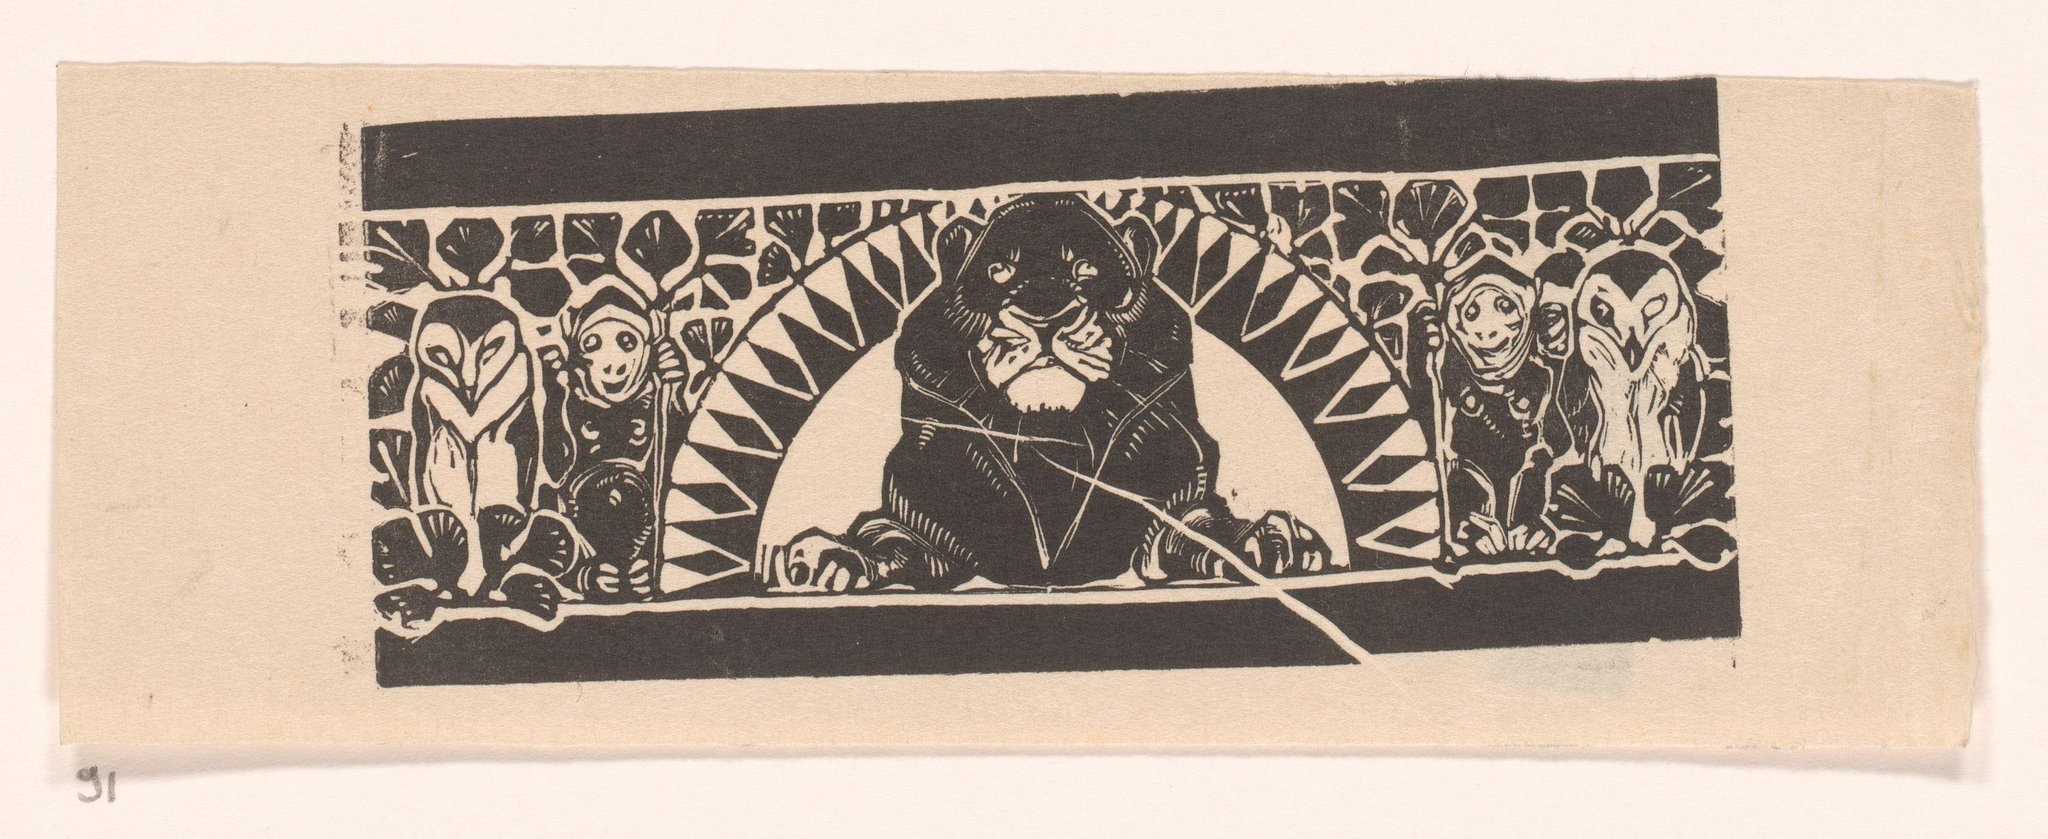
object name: boekillustratie ontwerp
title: Leeuw, uilen en apen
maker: bernard willem wierink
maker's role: draughtsman, print maker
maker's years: 1856-1939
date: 1910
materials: paper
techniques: relief print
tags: lion's head ~ ornament, monkeys, apes, owls, fable of reynard the fox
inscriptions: collector's mark: Lugt 2228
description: Ontwerp voor: Streuvels, Stijn (Frank Lateur). Reinaert de Vos naar verschillende uitgaven van het middeleeuwsche epos. Amsterdam: L.J. Veen, 1910. Deze prent is vermoedelijk een plaatsnede, ook al wordt in de literatuur veelal gesproken over een houtsnede. Voor zover Wierink zijn prenten in hoogdruk zelf nader heeft omschreven, heeft hij altijd de term 'plaatsnede' gebruikt.